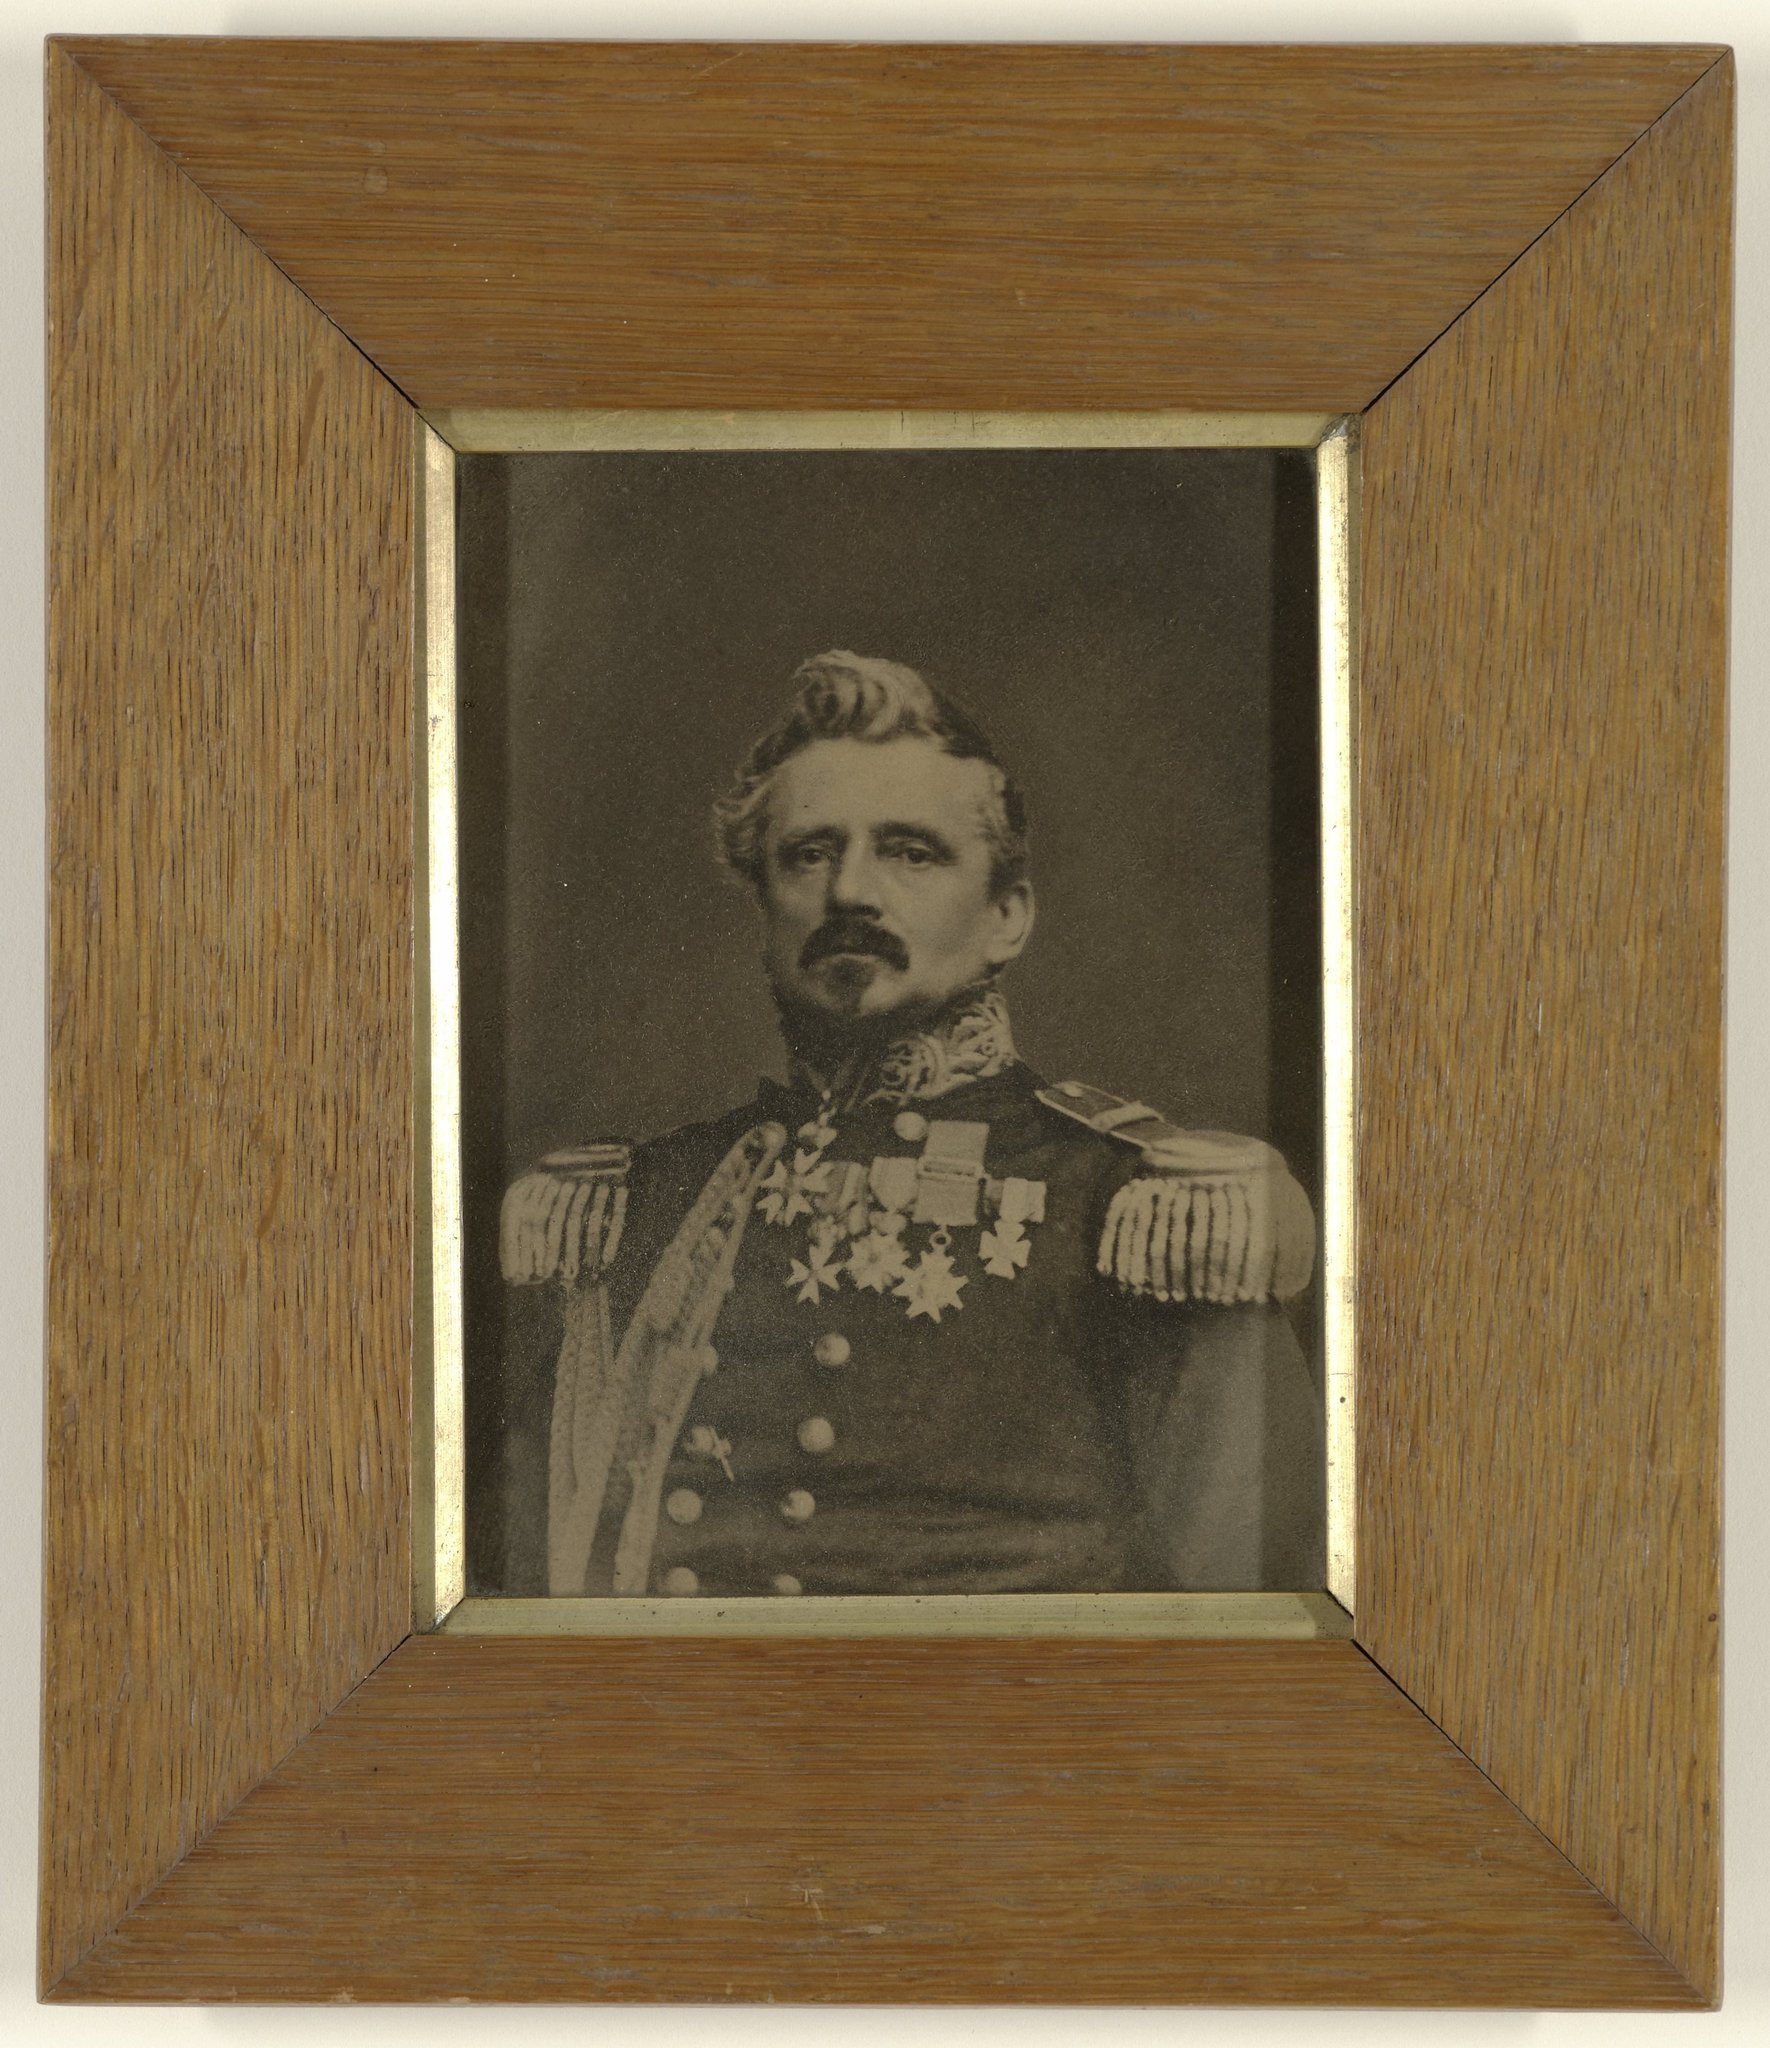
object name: photograph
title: Portret van schout bij nacht J.E. de Man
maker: Anonymous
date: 1850-1875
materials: glass, board, paper, wood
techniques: framing, photography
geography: netherlands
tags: utrecht, naval officer, historical persons, japan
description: Portret van schout bij nacht J.E. de Man. Ingelijste foto, portret van schout bij nacht Jacobus Eliza de Man, borststuk naar rechts met baard, in uniform met epauletten en vijf ridderordes op de borst; ingelijst achter glas, met brede houten lijst met vergulde houten binnenlijst. Achterkant: met de hand beschreven blaadje, op hardboard geplakt, met gegevens over de man en de ridderordes. Opschrift. Keerzijde: 'Schout bij nacht. voor Simoneseki / Nederlandsch eskader naar Japan / Commandant-divisiecommandant 1864. 5-10 Sept'.